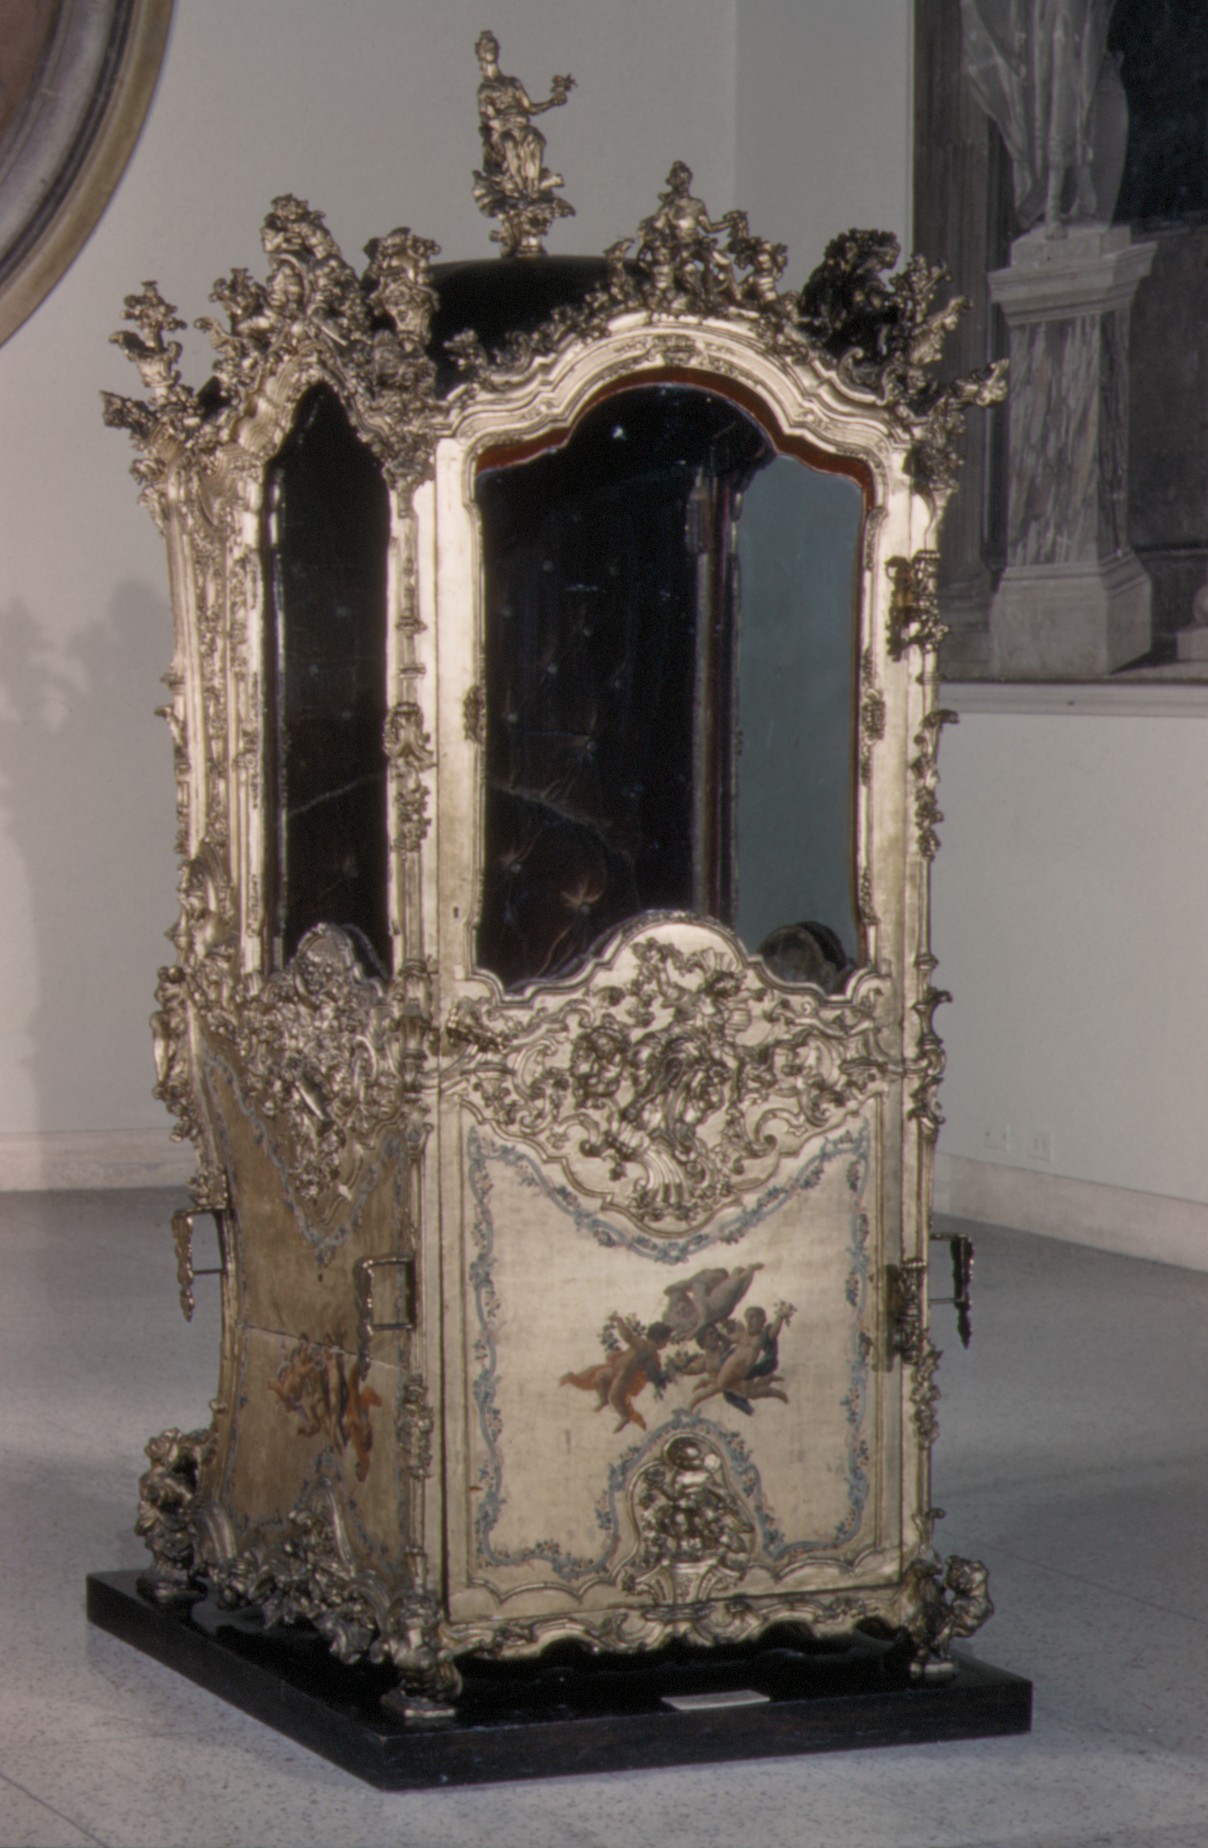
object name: sedan chair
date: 1750-1760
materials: gilt bronze, leather, wood, velvet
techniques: carving, gilding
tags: female nudes,cupid,horses,lions